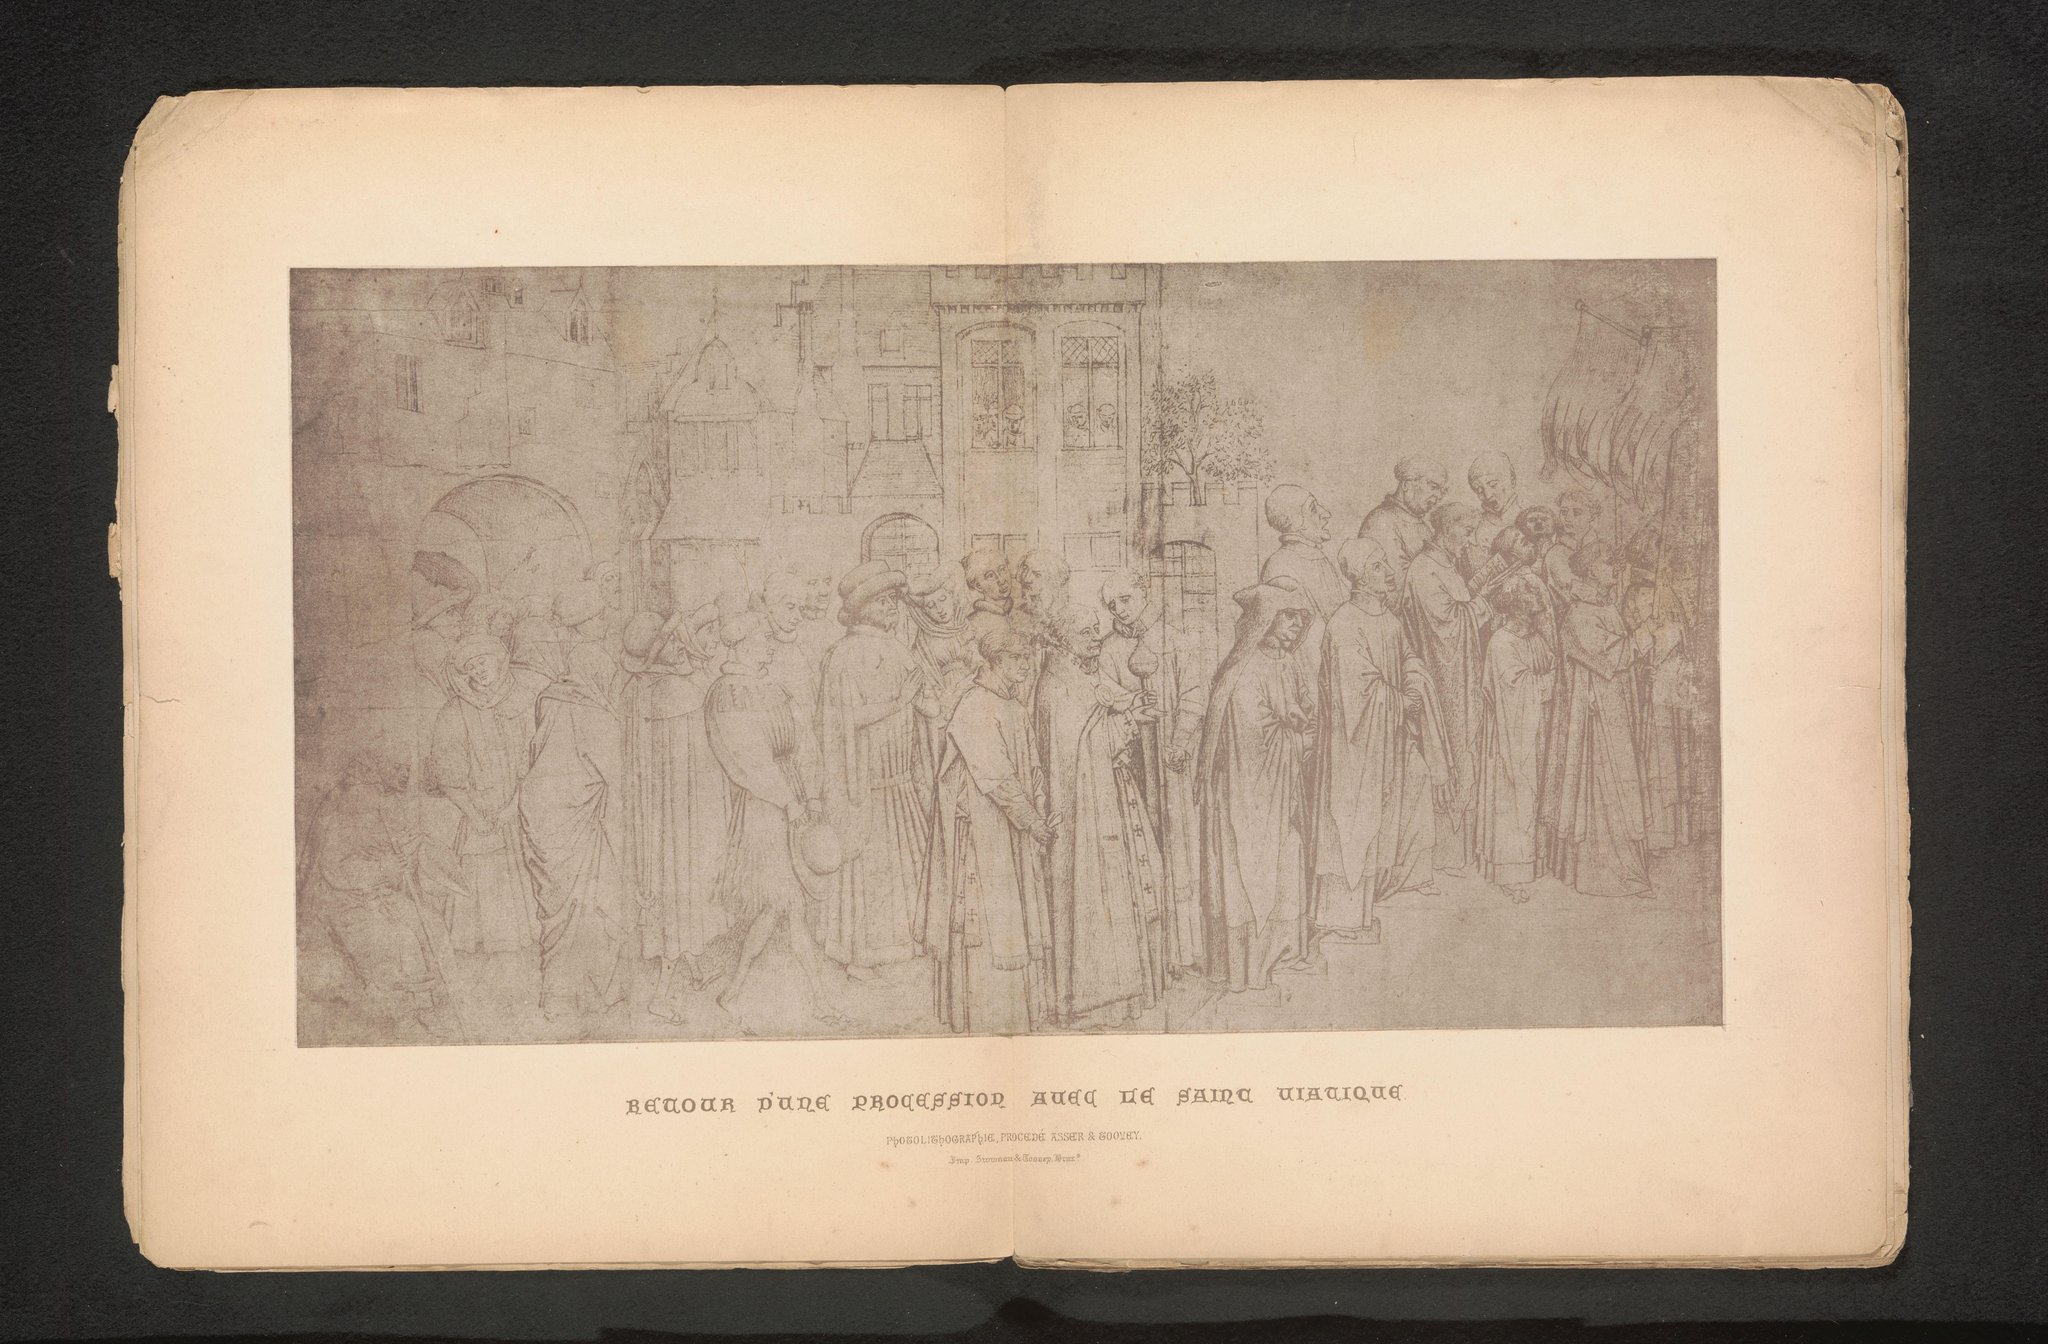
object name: reproduction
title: Reproductie van een prent van de terugkomst van een processie van de heilige viaticum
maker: Anonymous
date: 1860-1865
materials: paper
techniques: photolithography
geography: brussels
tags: procession ~ christian religion, last communion, administering of the holy viaticum